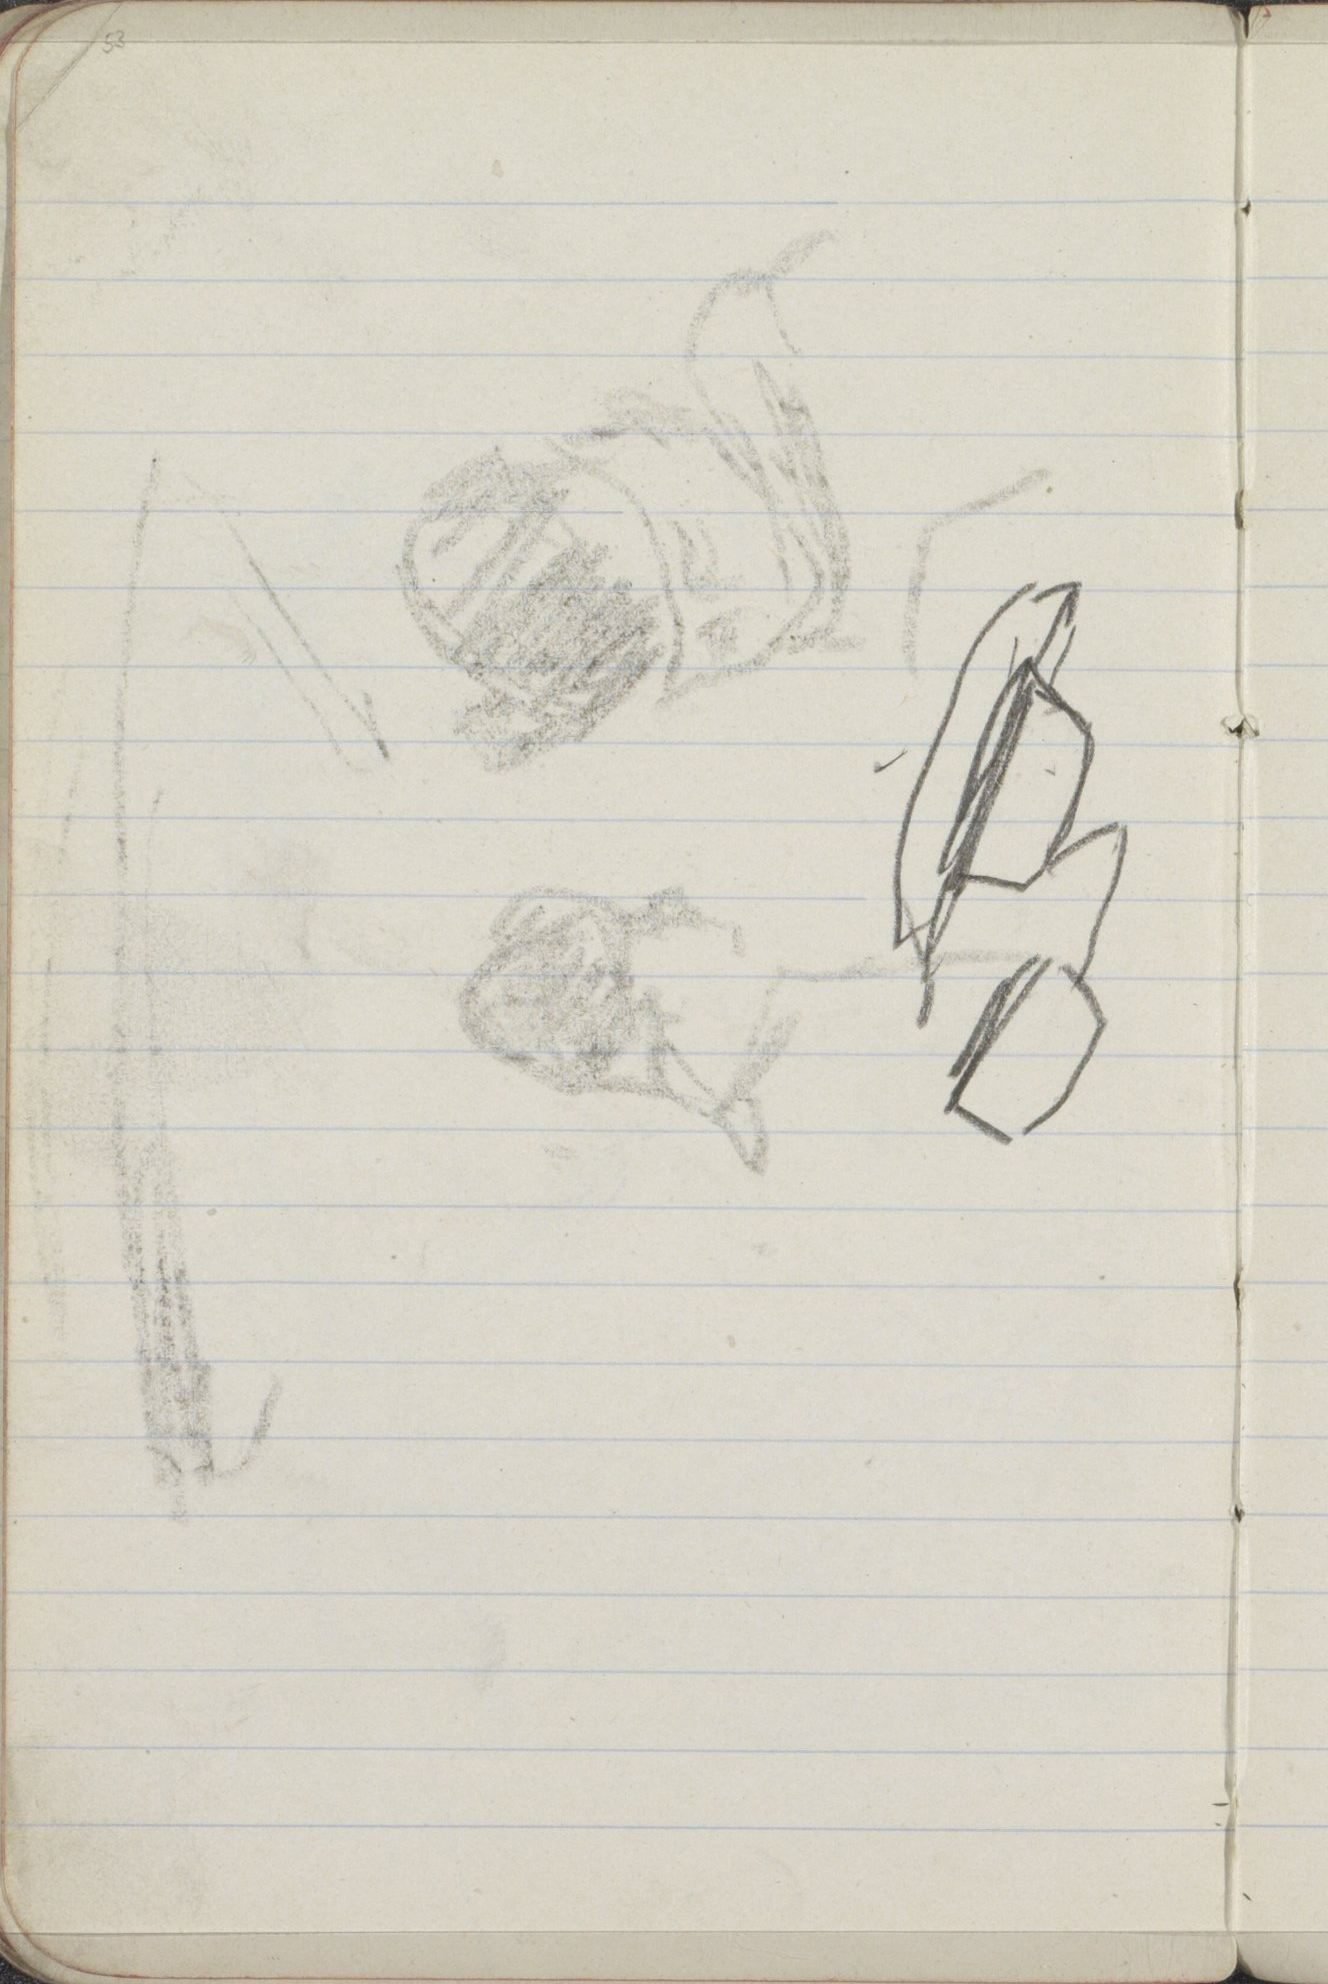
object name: sketchbook leaf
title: Twee hoeden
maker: george hendrik breitner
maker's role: draughtsman, painter, print maker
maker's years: 1857-1923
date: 1890-1900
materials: chalk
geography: amsterdam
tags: head-gear: hat (+ men's clothes)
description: Pagina 53 uit een schetsboek met 33 bladen.